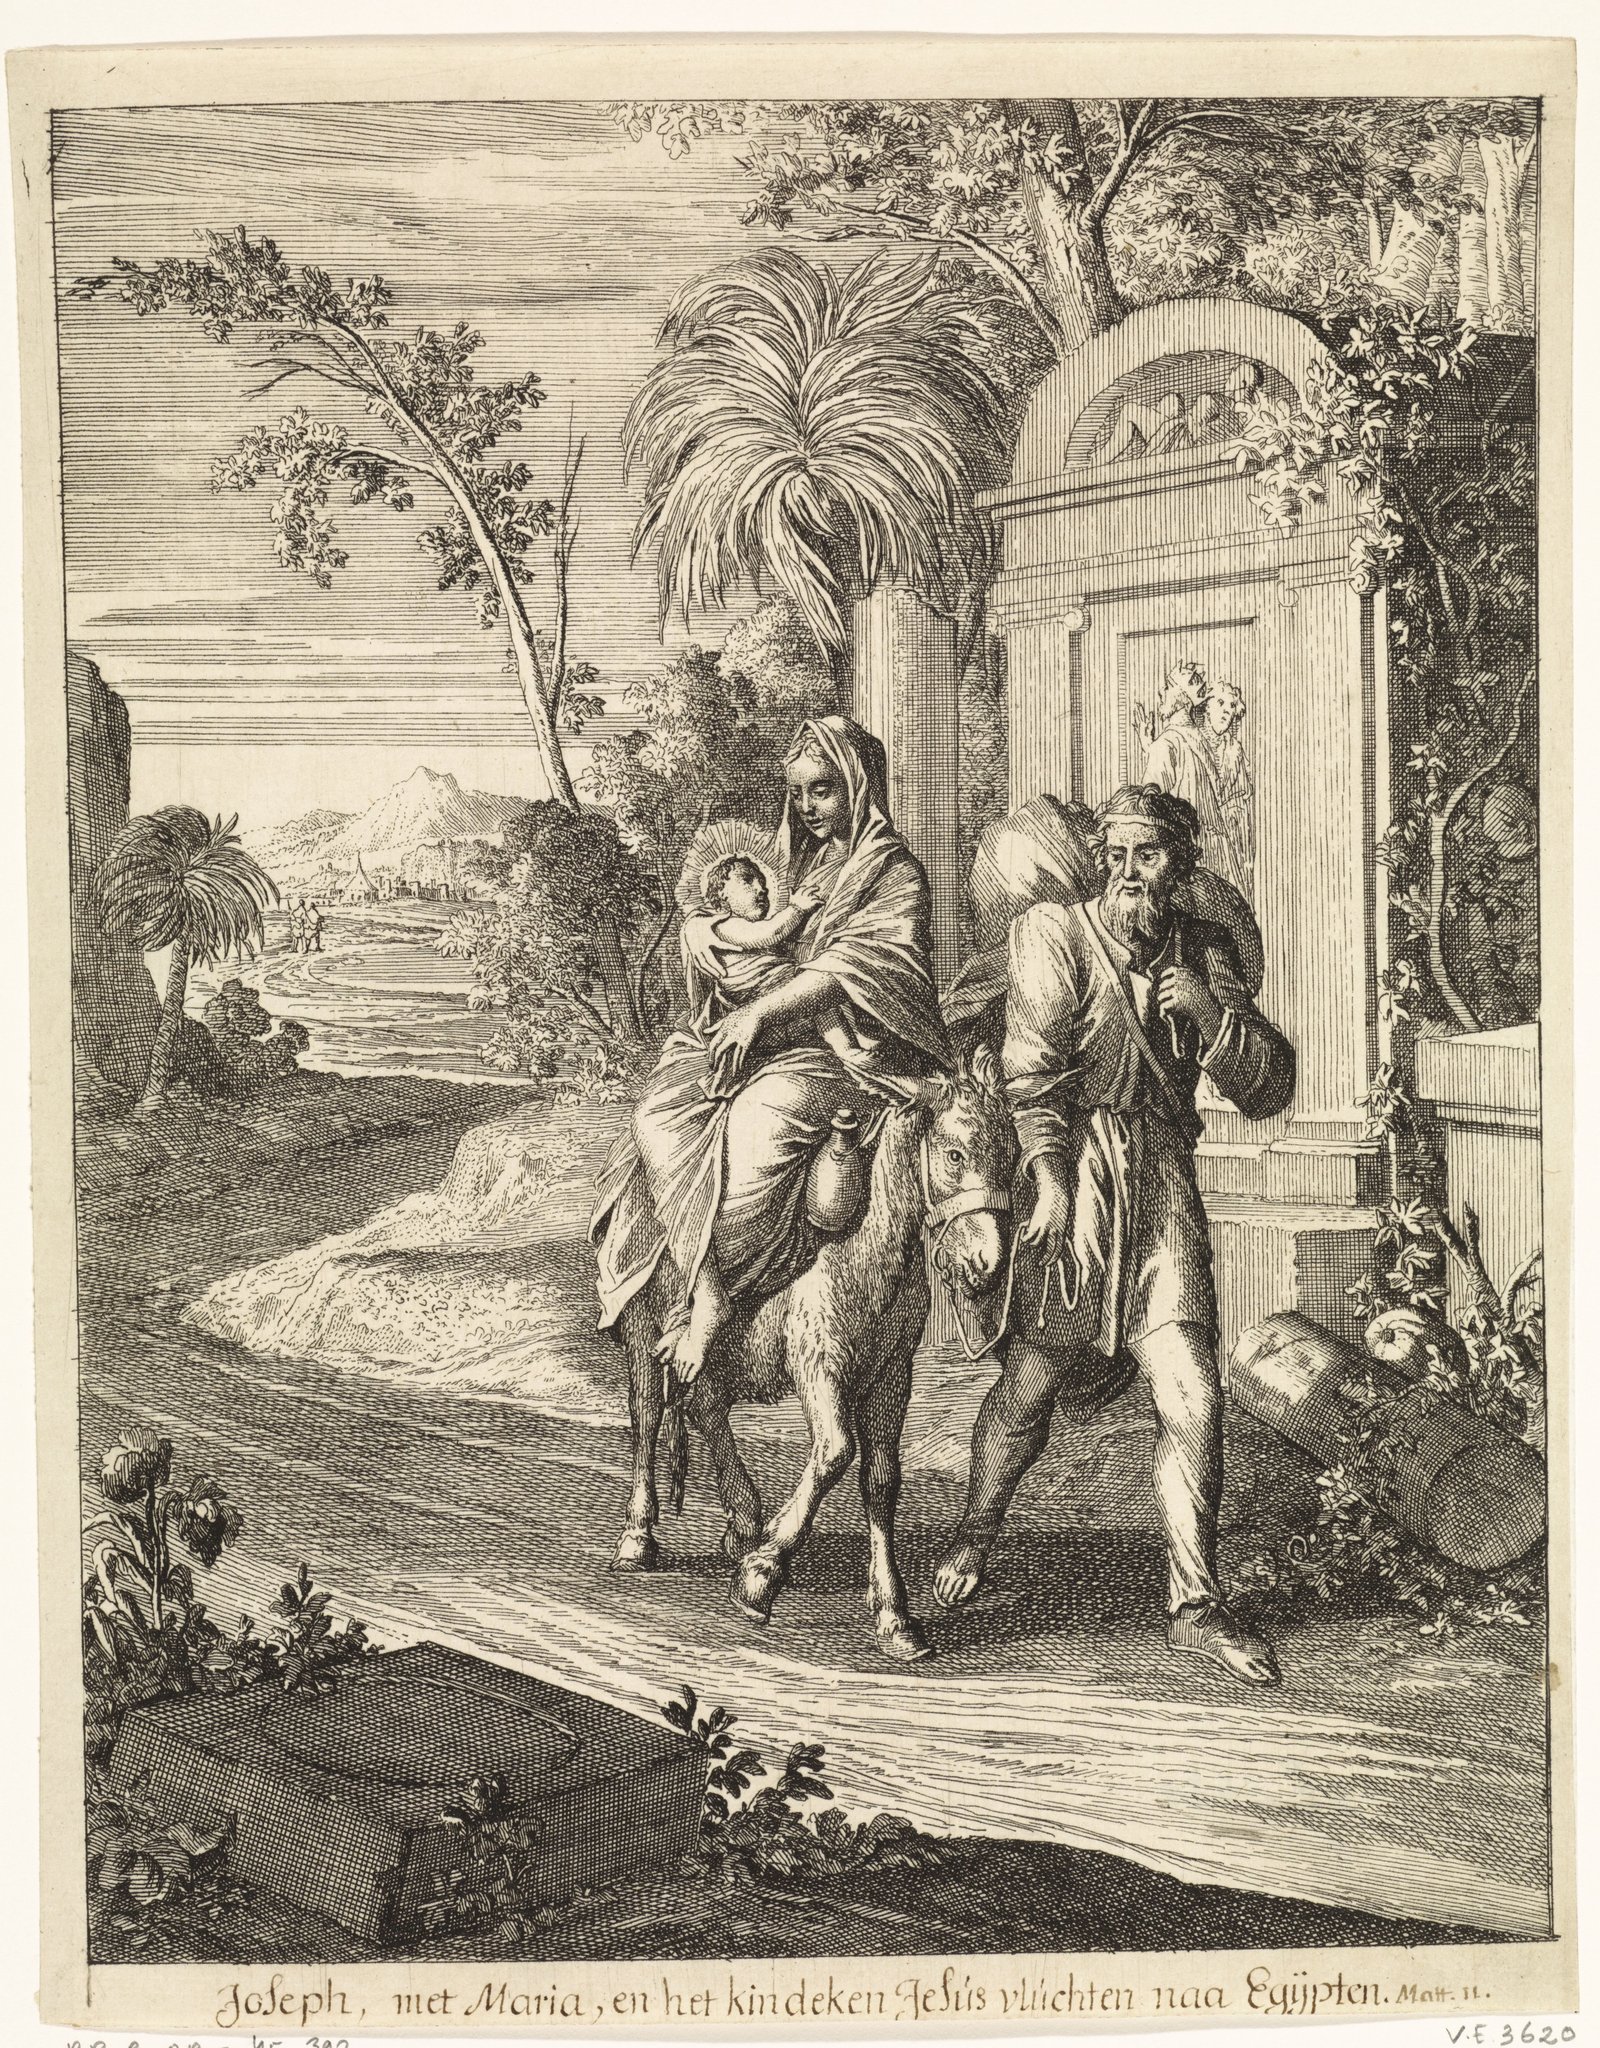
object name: print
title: Vlucht naar Egypte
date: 1708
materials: paper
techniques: etching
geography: nuremberg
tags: the flight into egypt: mary, joseph, the child (and sometimes others) on their way; mary usually riding on an ass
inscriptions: collector's mark: Lugt 2228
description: Proefdruk van een prent welke is opgenomen als illustratie in: Historiae Celebriores Veteris Testamenti. Christoph Weigel, 1708.